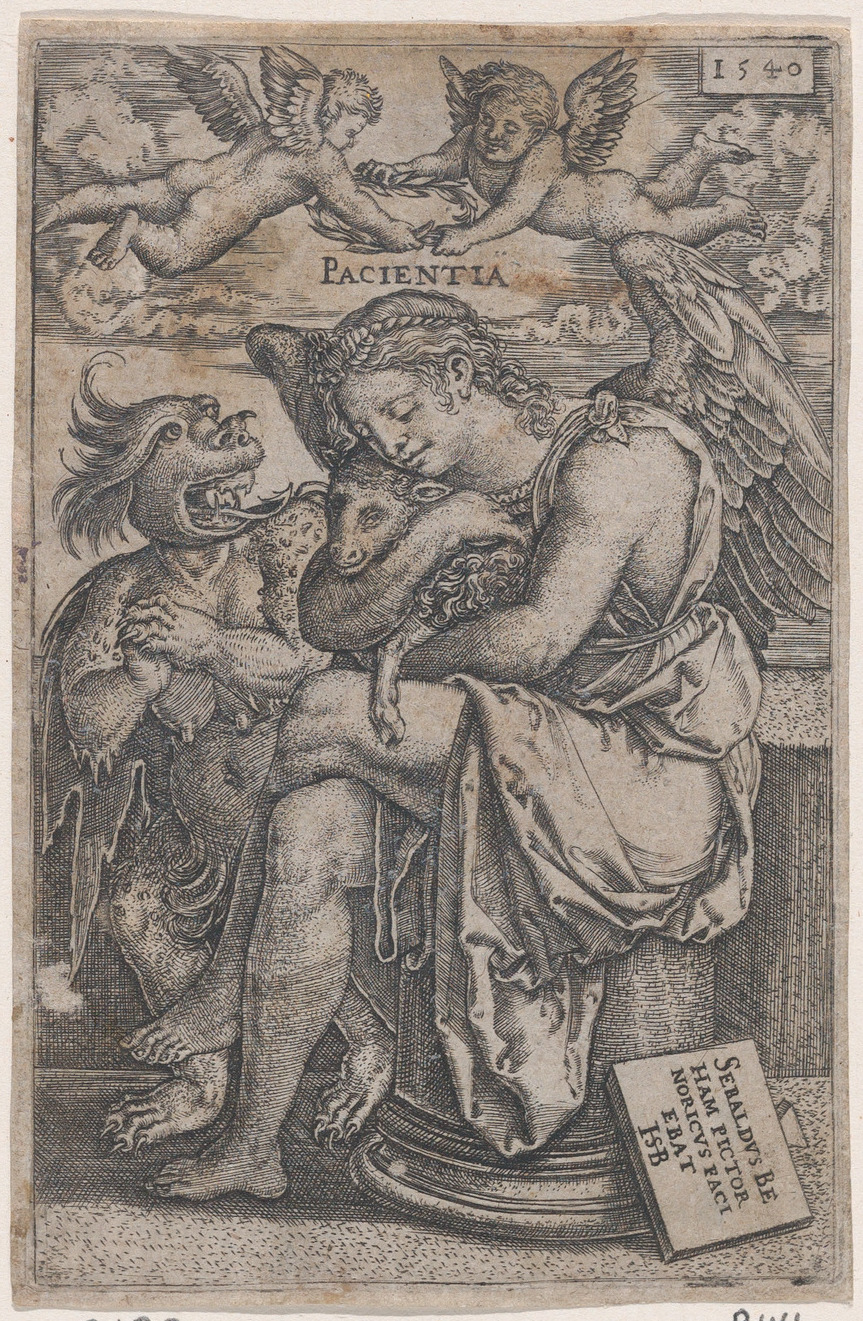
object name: print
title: Patience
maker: Anonymous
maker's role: artist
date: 1540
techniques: engraving